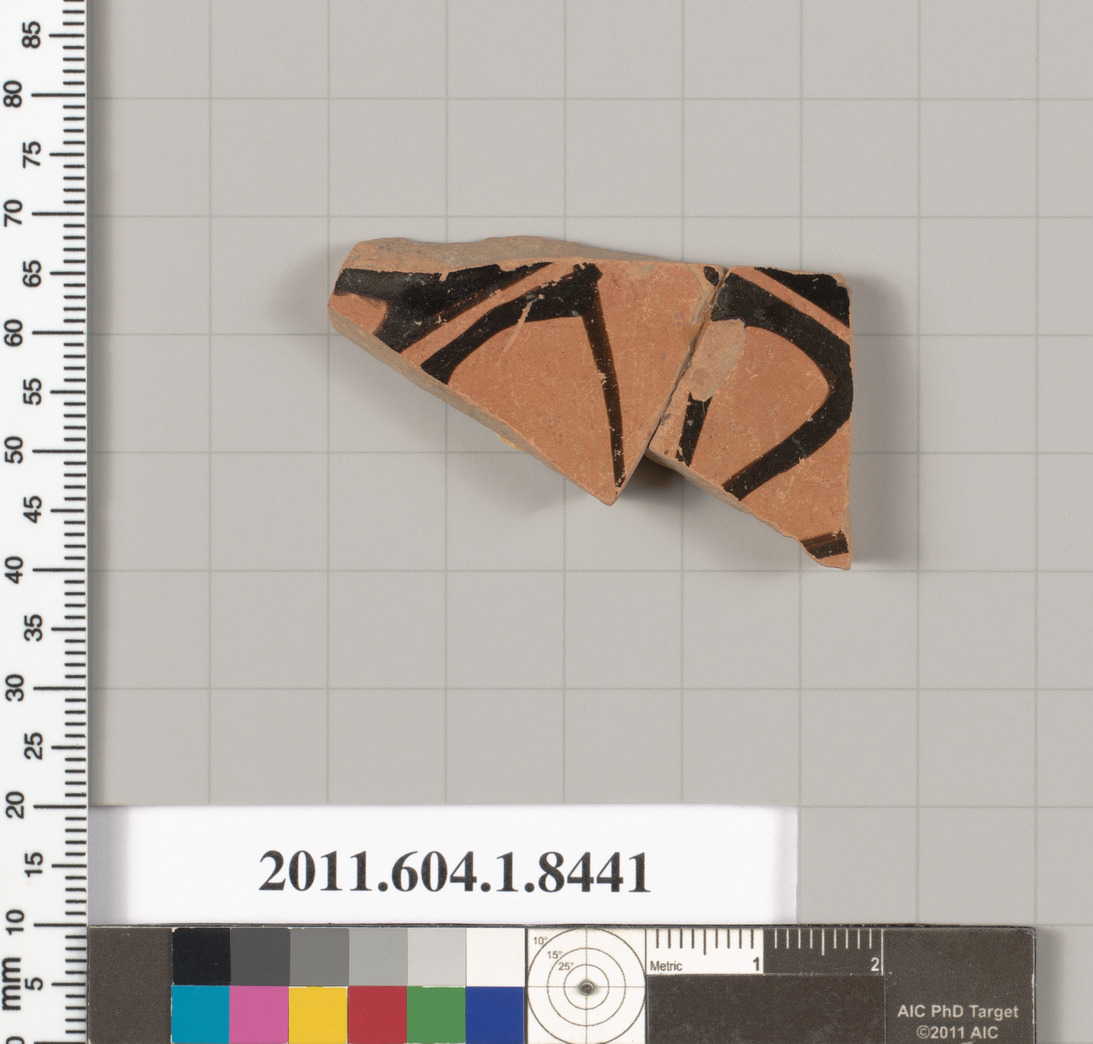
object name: kylix fragment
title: Terracotta fragment of a kylix (drinking cup)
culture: greek, attic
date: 400-351 BCE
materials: terracotta